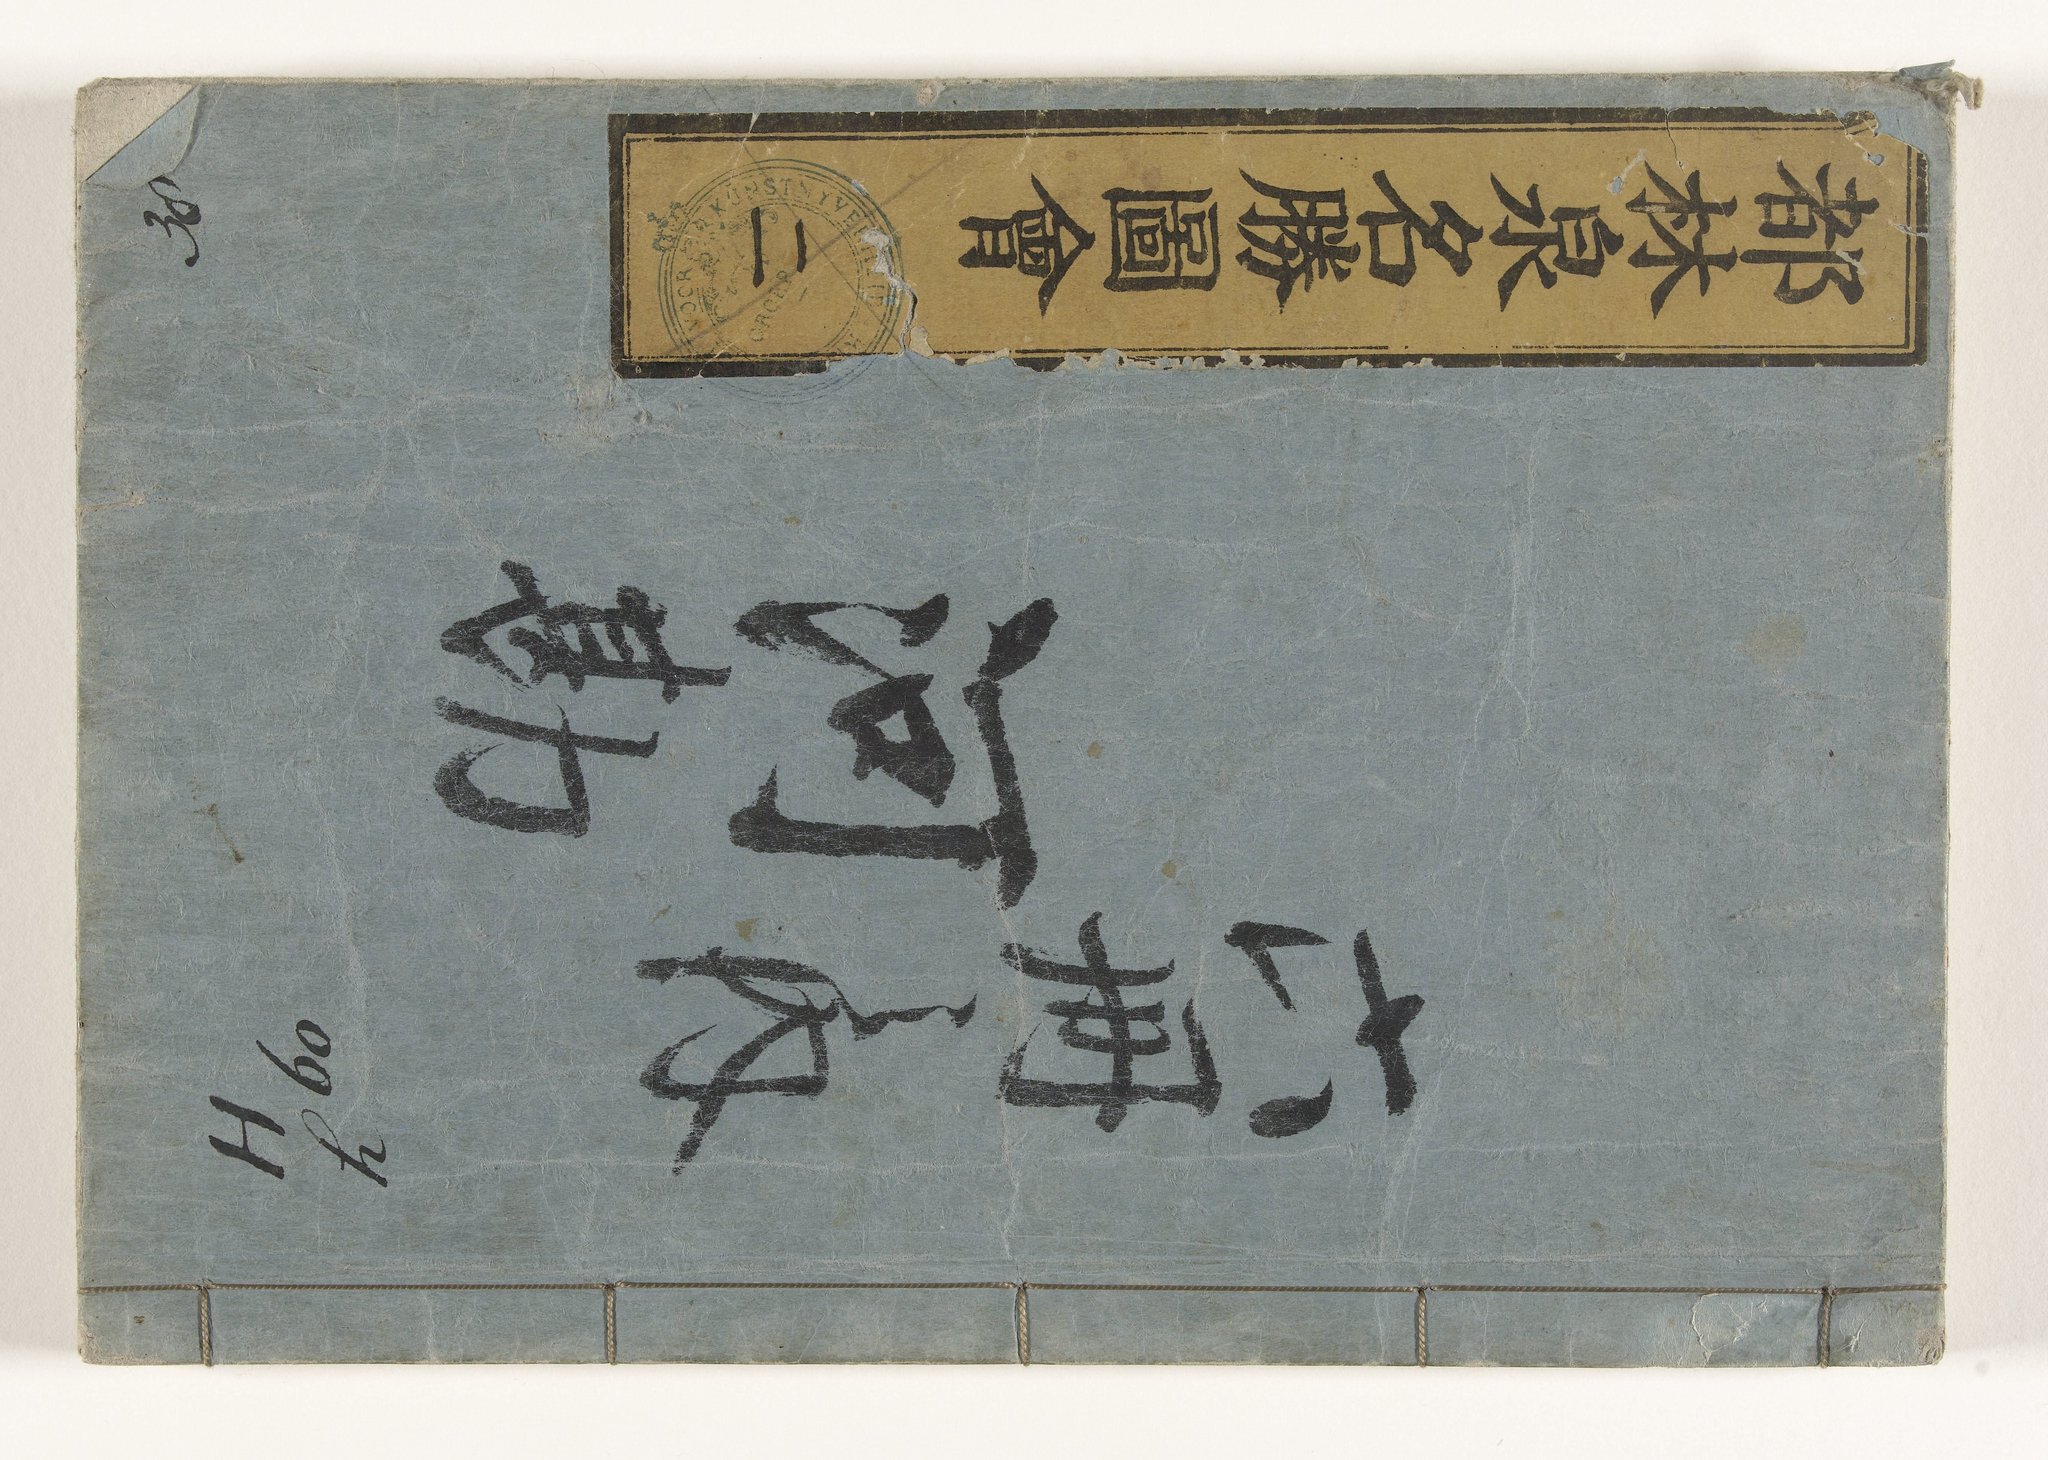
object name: book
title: Beroemde landschapstuinen in Kyoto - deel twee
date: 1799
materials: paper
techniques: woodcut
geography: kyoto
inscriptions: collector's mark: ‘Rijksschool voor kunstnijverheid’ Lugt 3937